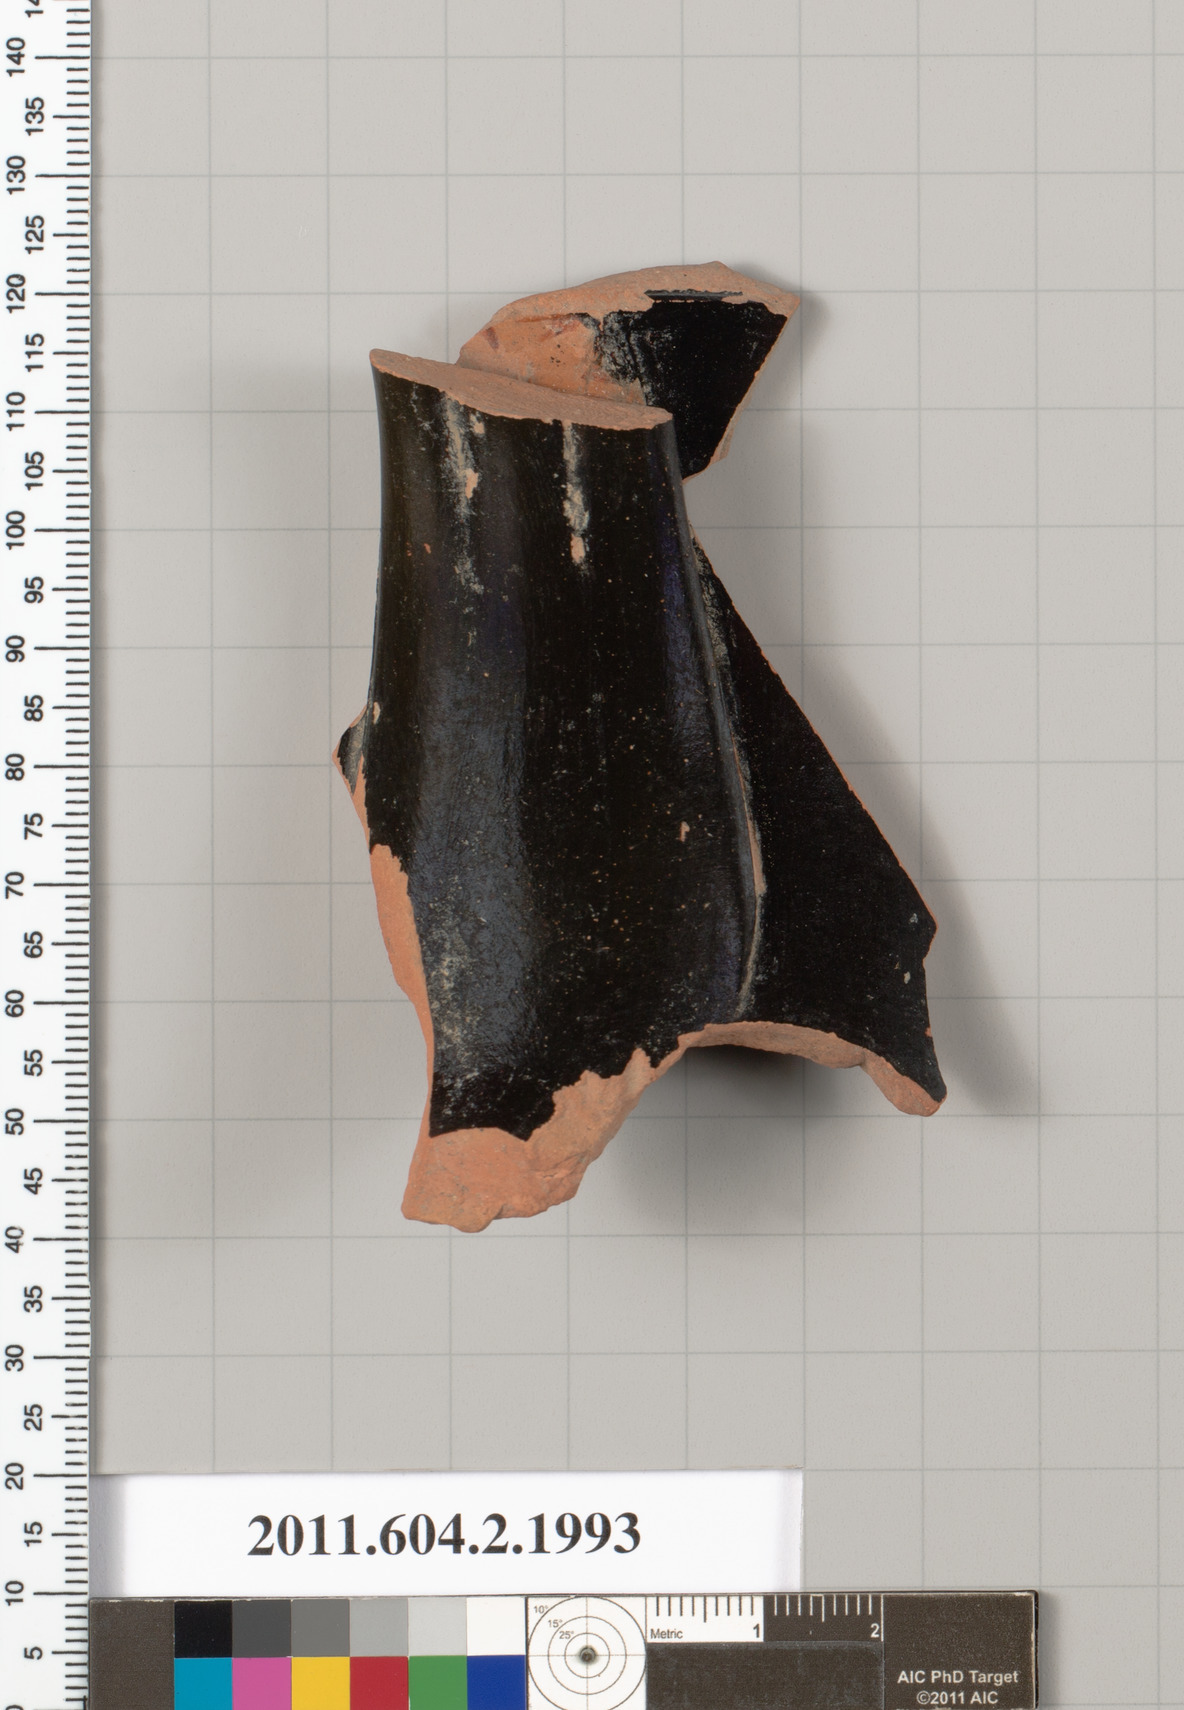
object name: pelike fragment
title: Terracotta fragment of a pelike (jar)?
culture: greek, attic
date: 475-451 BCE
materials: terracotta